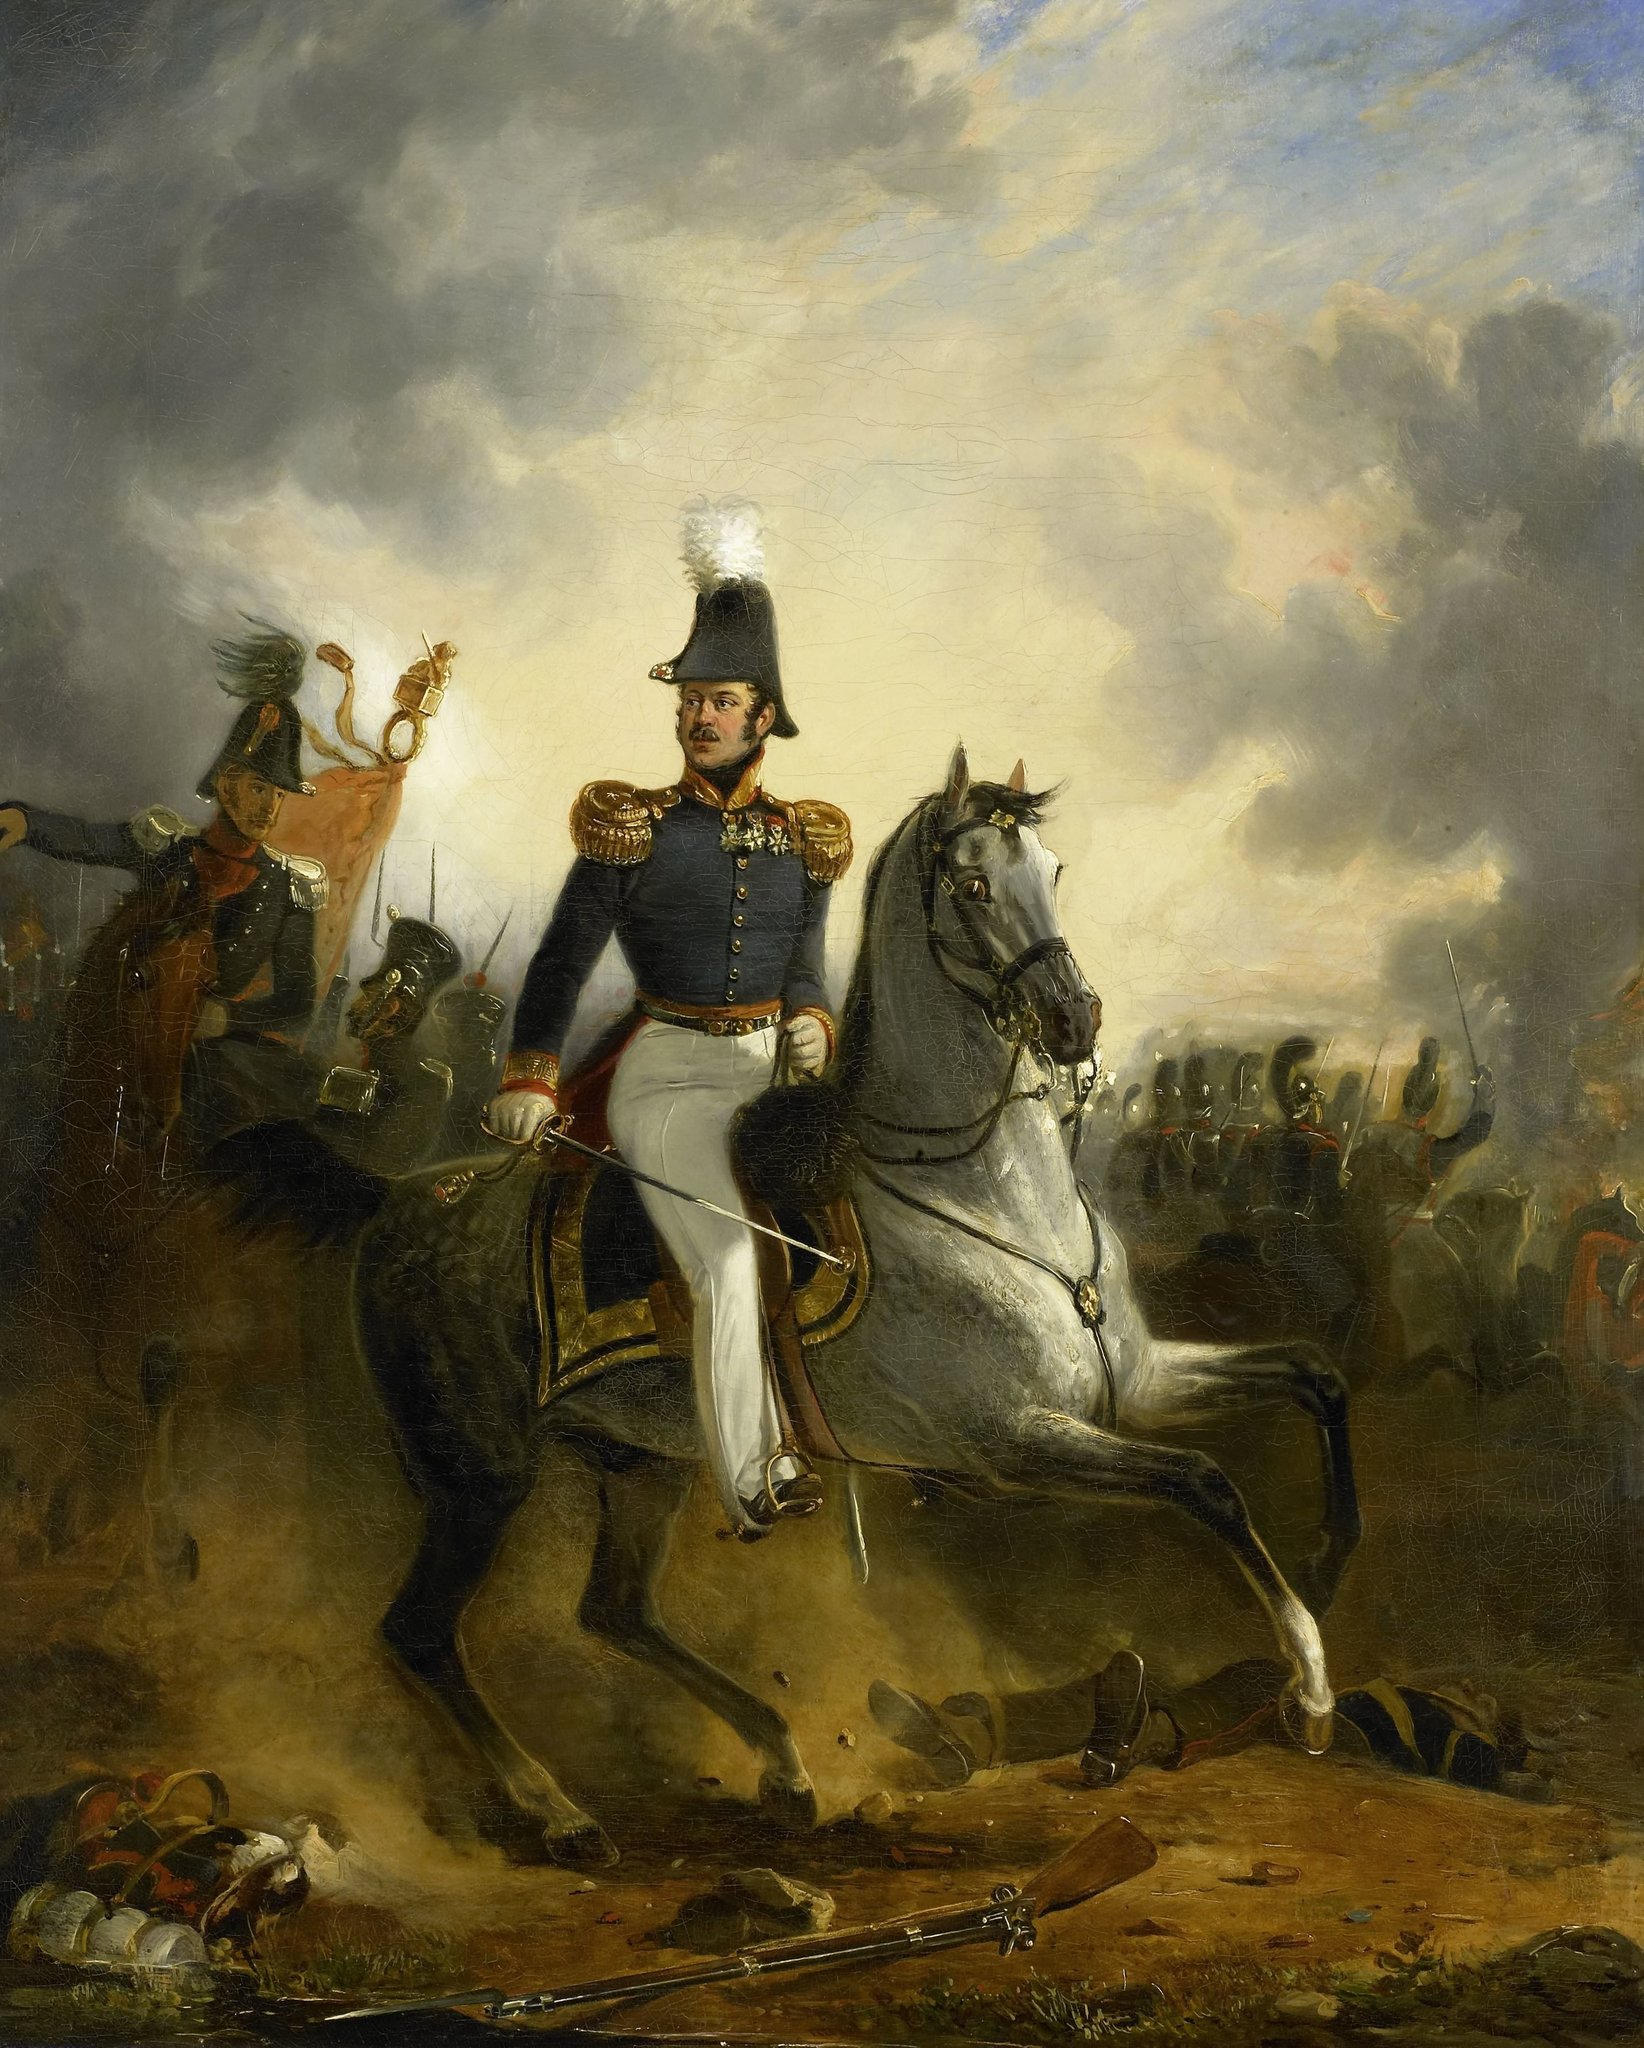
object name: painting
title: Lieutenant-General Frederik Knotzer in the Battle of Houthalen, during the 10 Days' Campaign, 1831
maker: nicolaas pieneman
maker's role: draughtsman, painter, print maker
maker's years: 1809-1860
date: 1834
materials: canvas, oil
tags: the hague, amerongen, historical persons, battle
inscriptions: signature and date: ‘N. Pieneman 1834’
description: Portret van luitenant-generaal Frederik Knotzer in de slag bij Houthalen, gedurende de Tiendaagse Veldtocht, 1831. Portret van de luitenant-generaal op een steigerend paard, degen in de rechterhand. Op de grond een gesneuvelde soldaat, links en op de achtergrond oprukkende troepen van de Amsterdamse Schutters en de Hollandse Kurassiers.